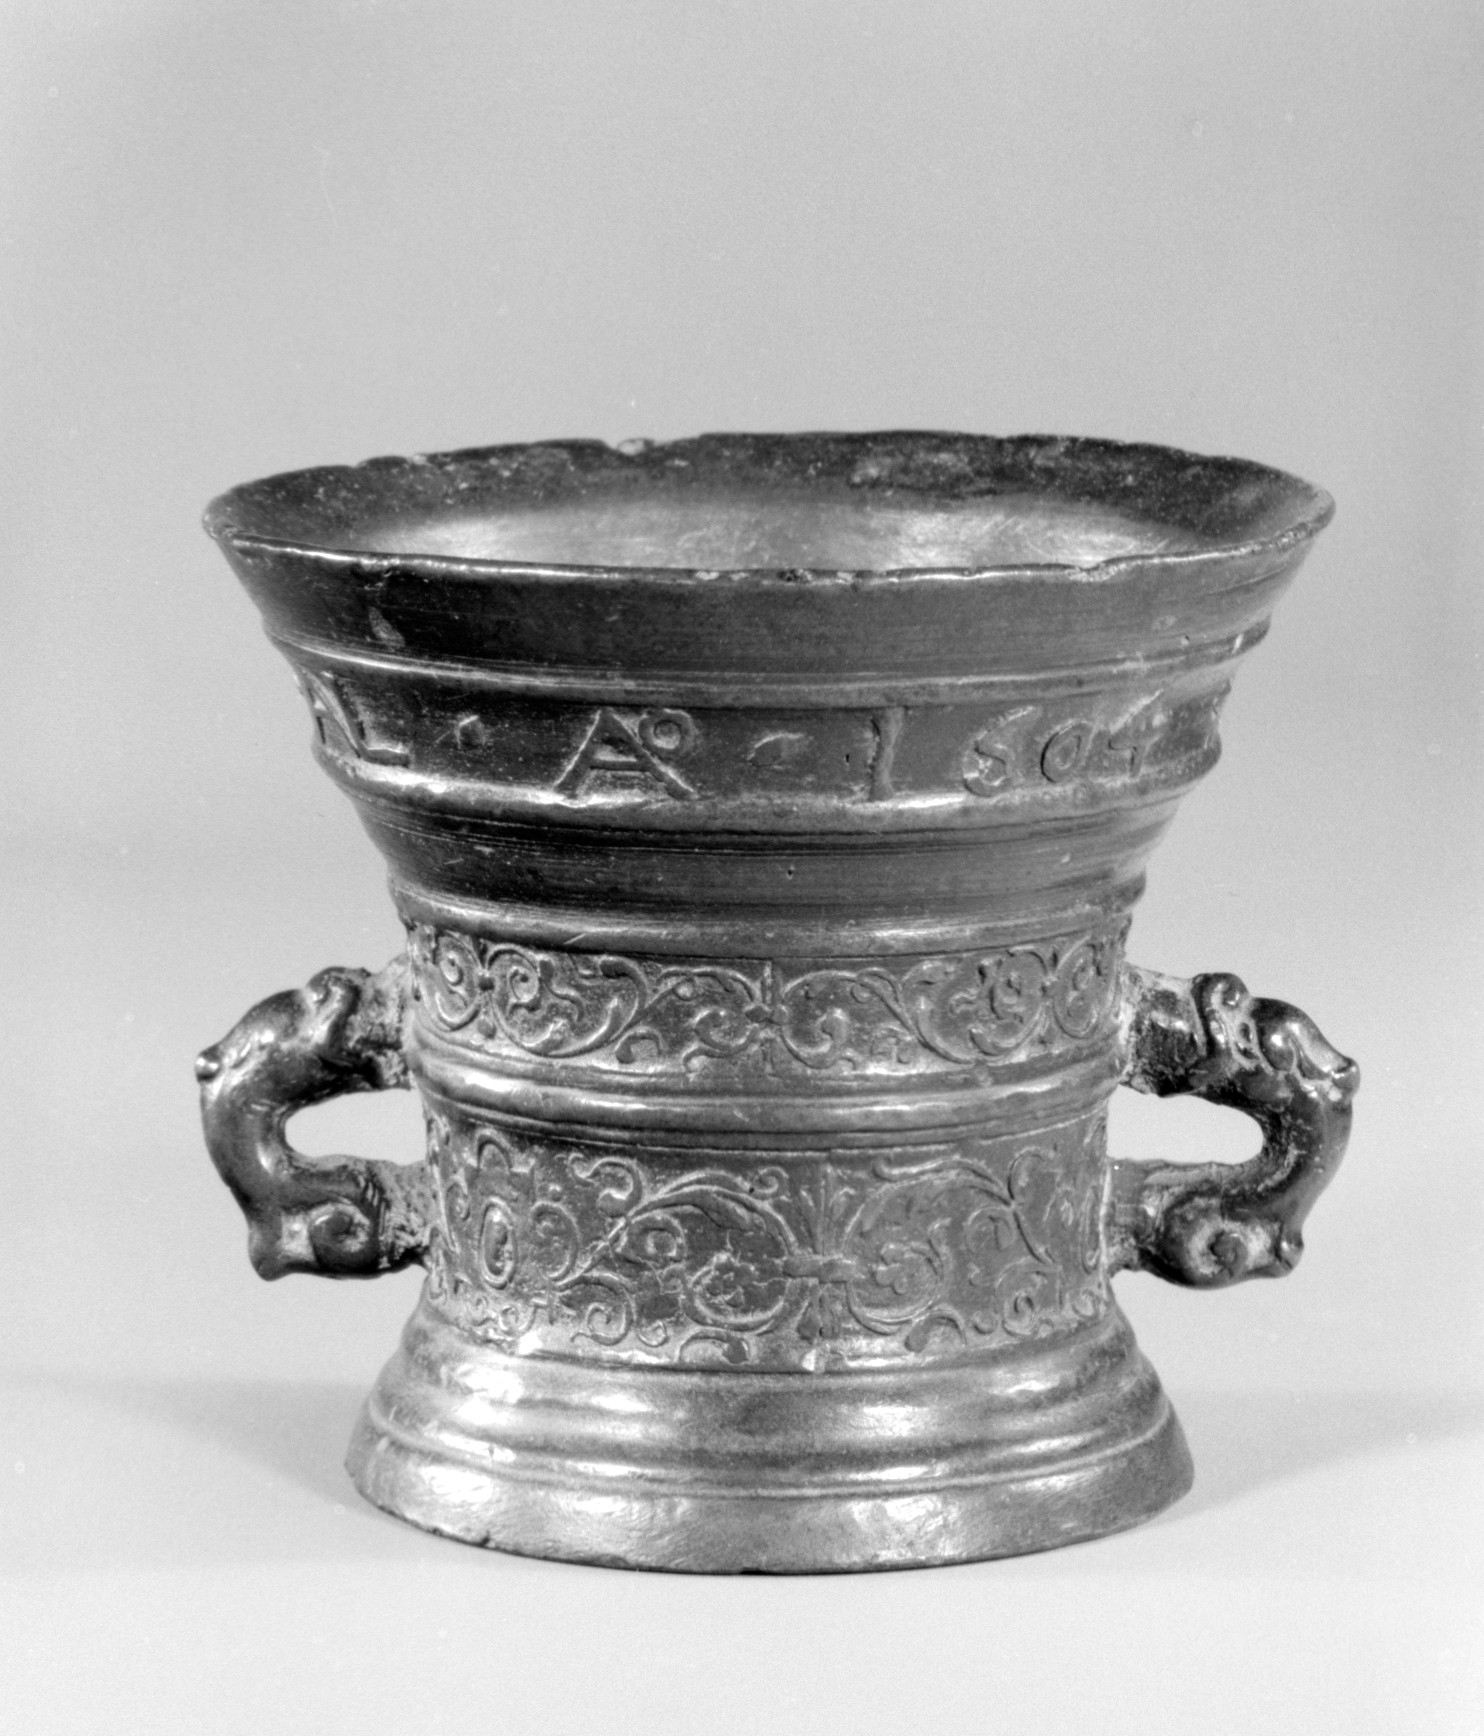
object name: mortar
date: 1504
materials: bronze